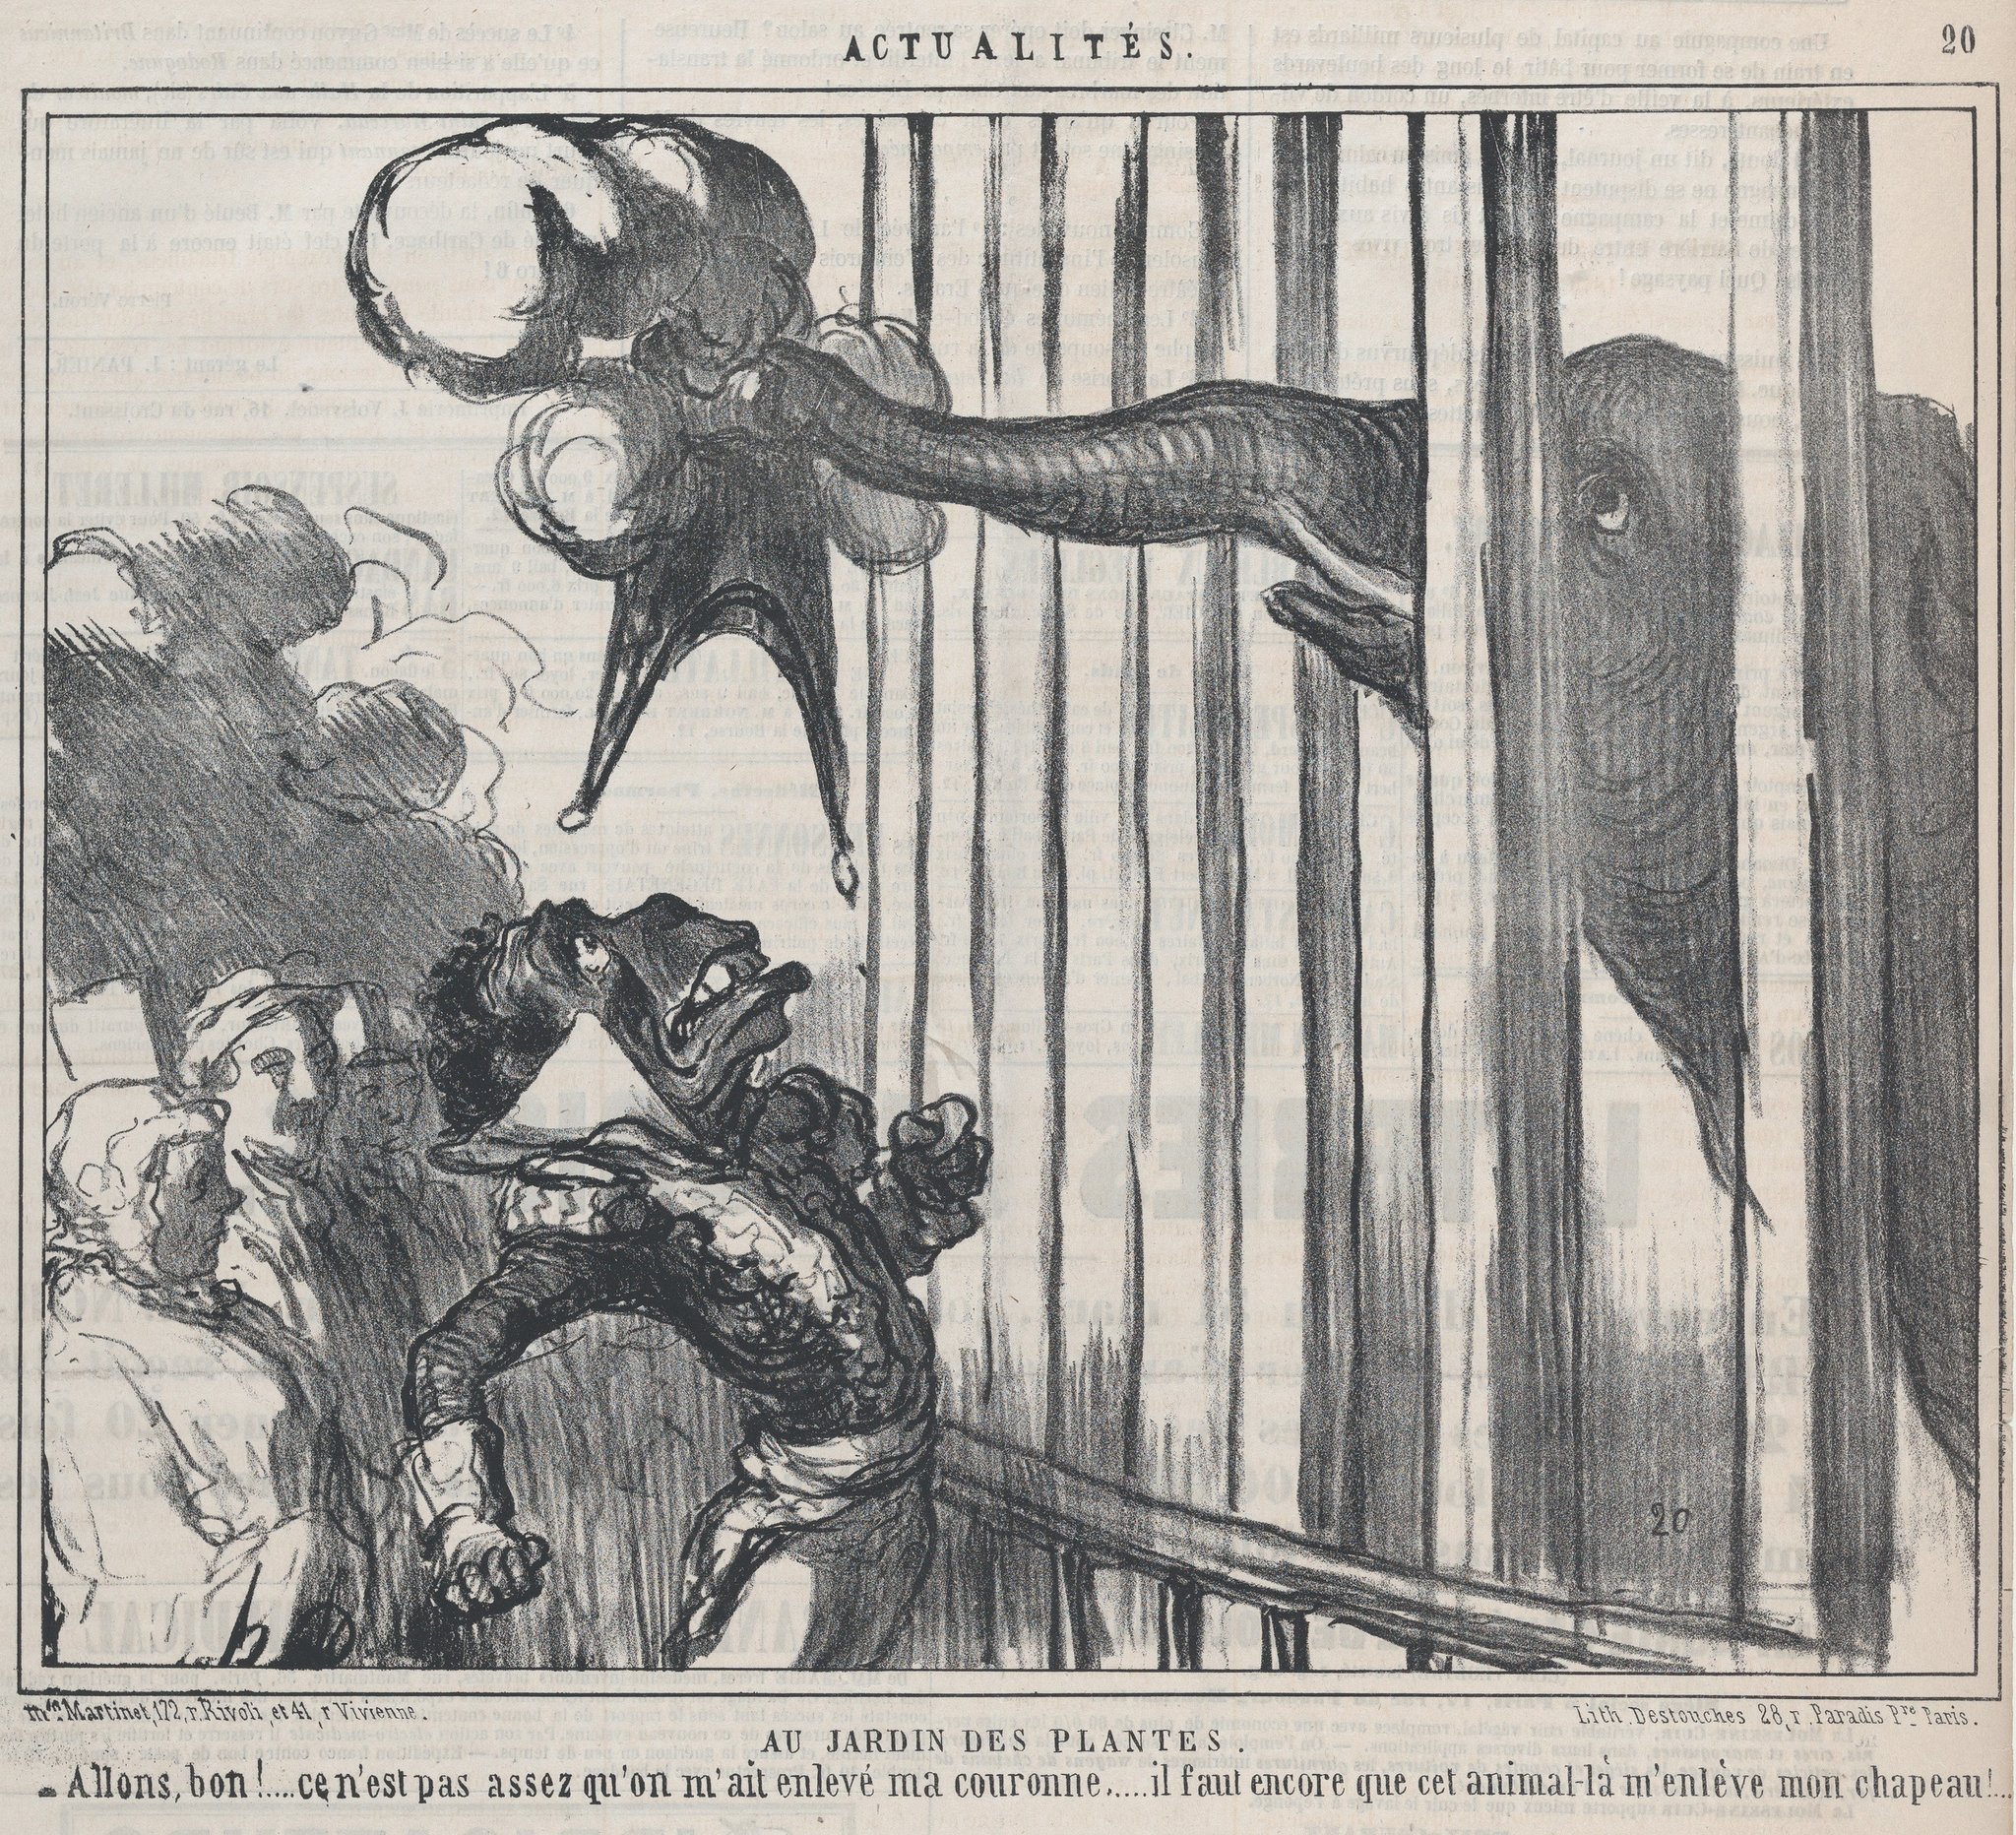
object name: print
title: Au Jardin des Plantes, from Actualités, published in Le Charivari, March 19, 1859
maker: honoré daumier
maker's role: artist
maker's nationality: french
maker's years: 1808-1879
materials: paper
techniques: lithograph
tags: men,women,spectators,elephants